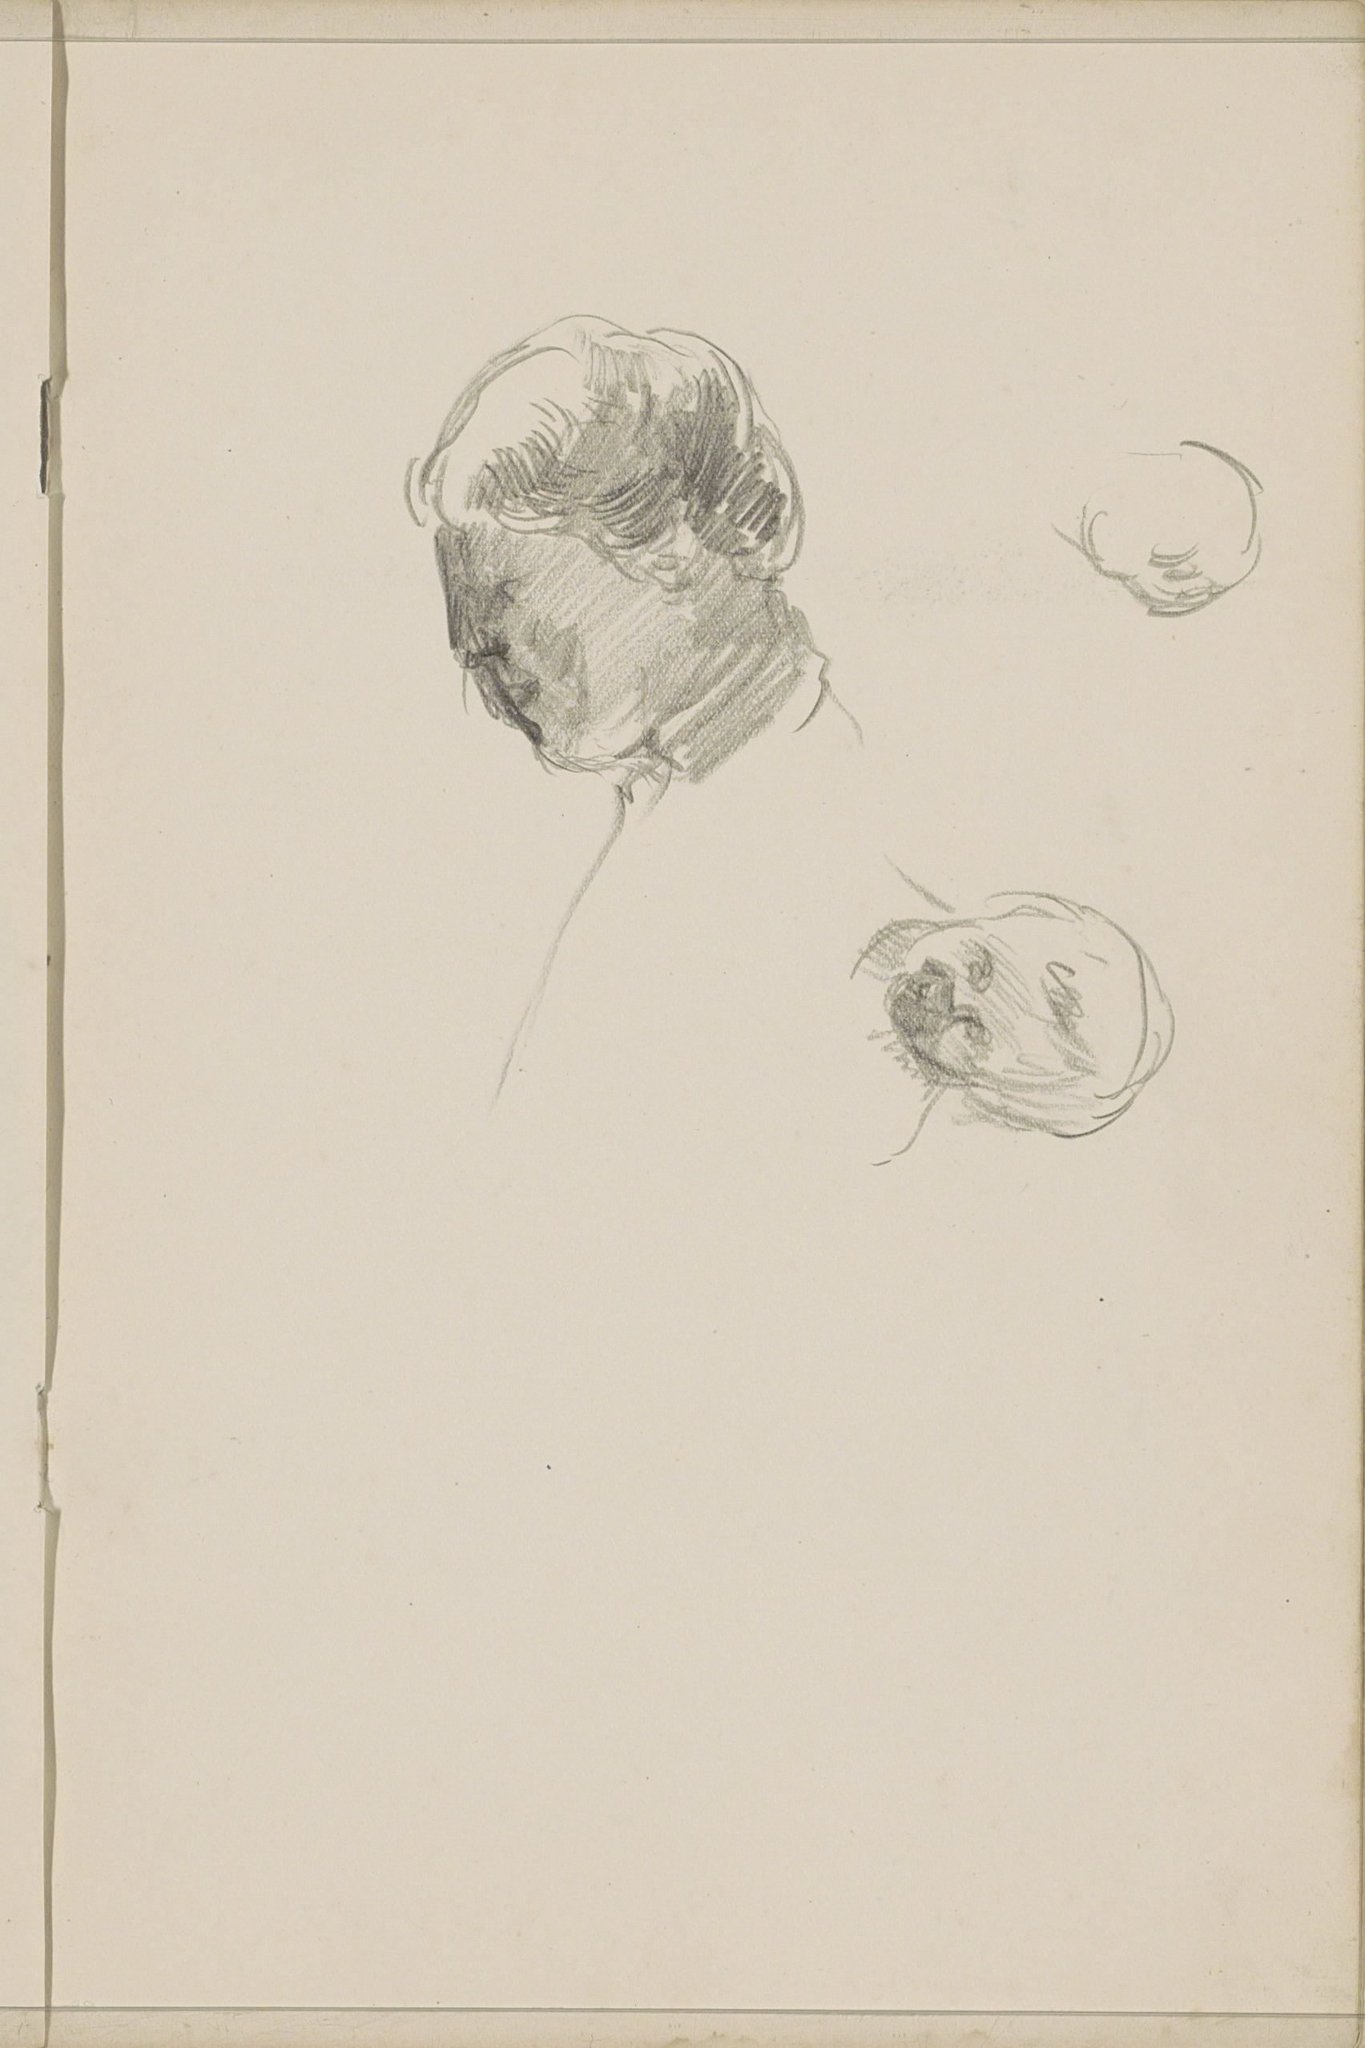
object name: sketchbook leaf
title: Koppen van een man en een kind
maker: cornelis vreedenburgh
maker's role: draughtsman, print maker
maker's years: 1880-1946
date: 1890-1946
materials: paper, pencil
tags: head (human)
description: Blad 9 recto uit een schetsboek met 47 bladen.